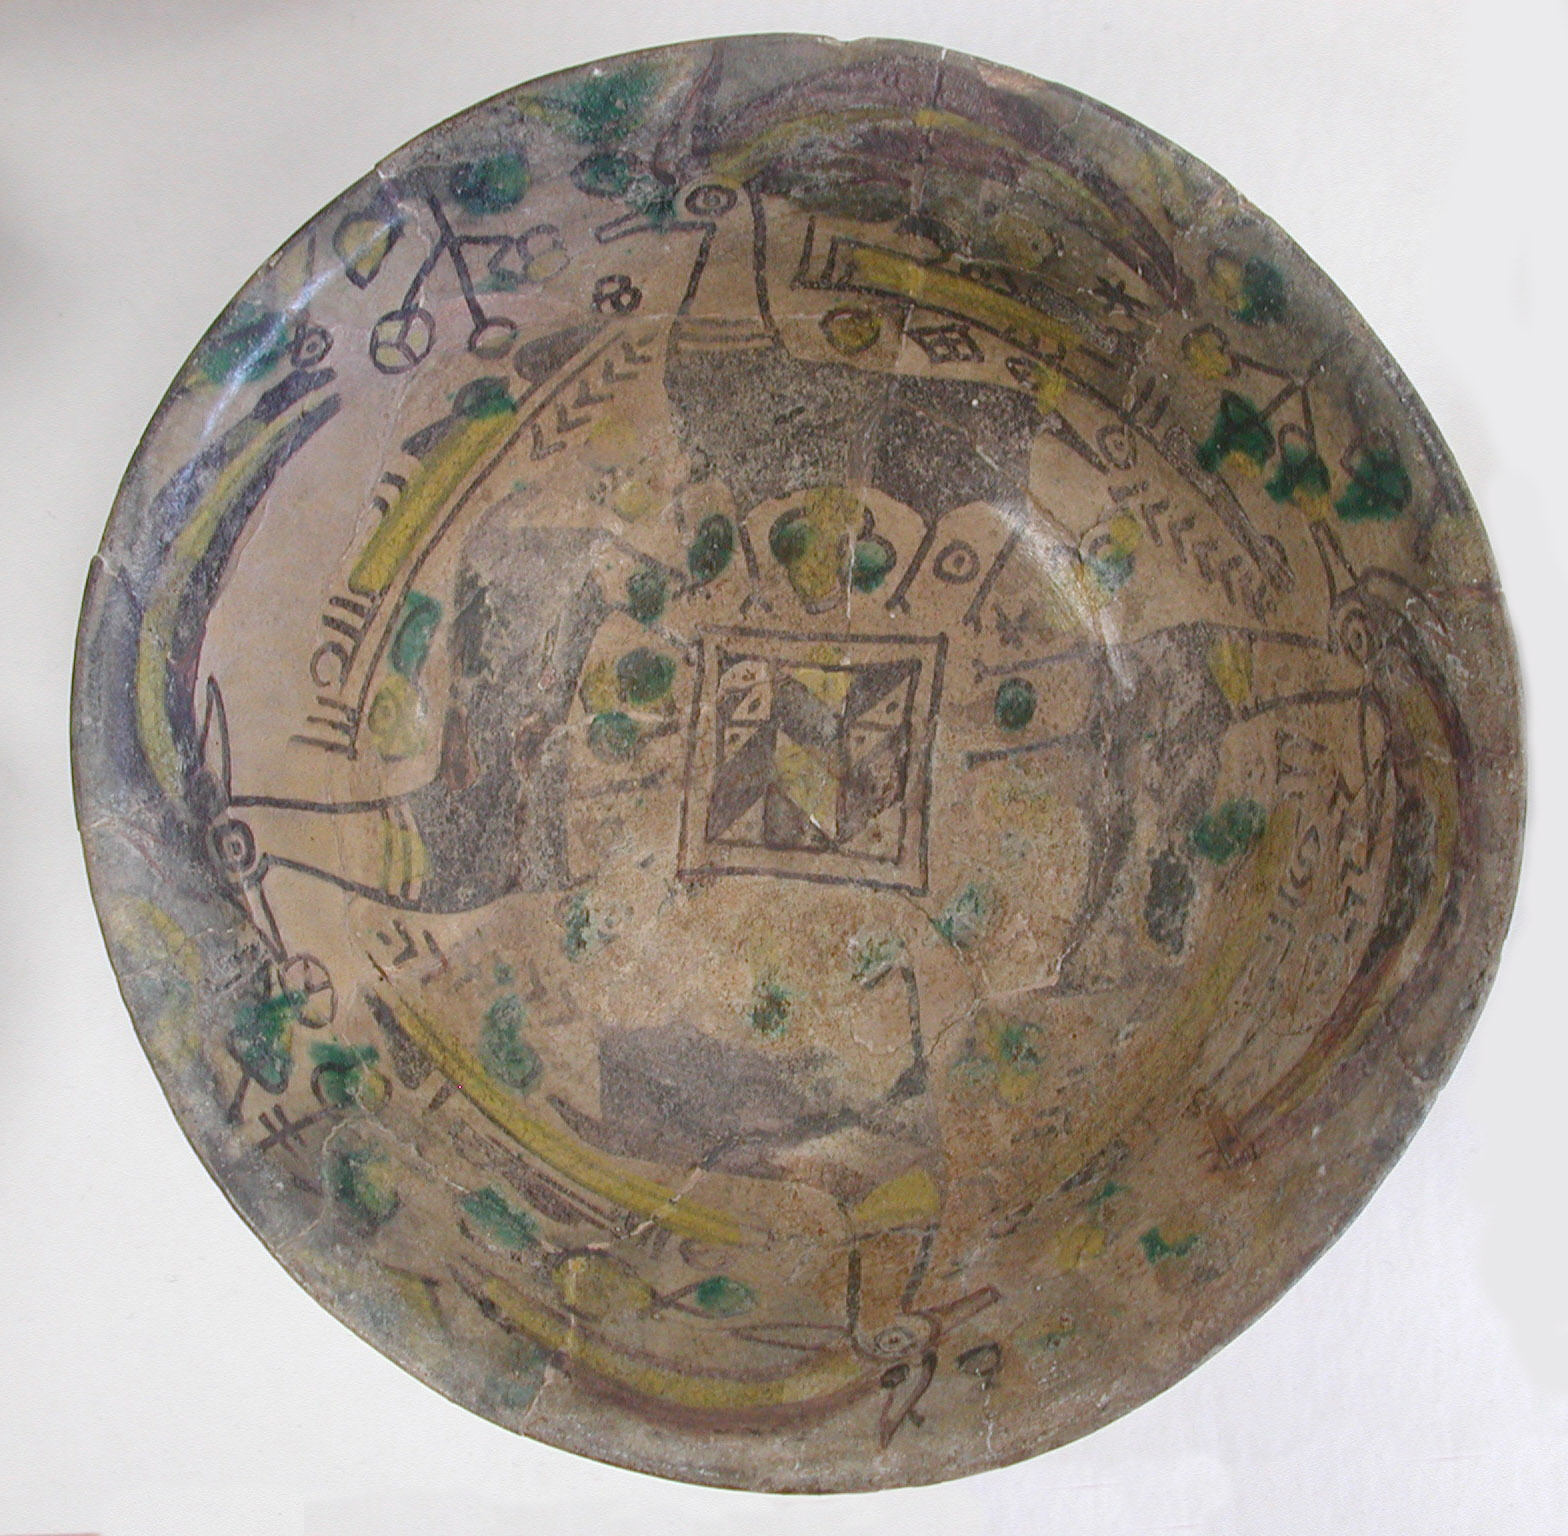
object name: bowl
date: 701-900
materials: earthenware, glaze, pigment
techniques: painting, polychrome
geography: iran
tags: birds